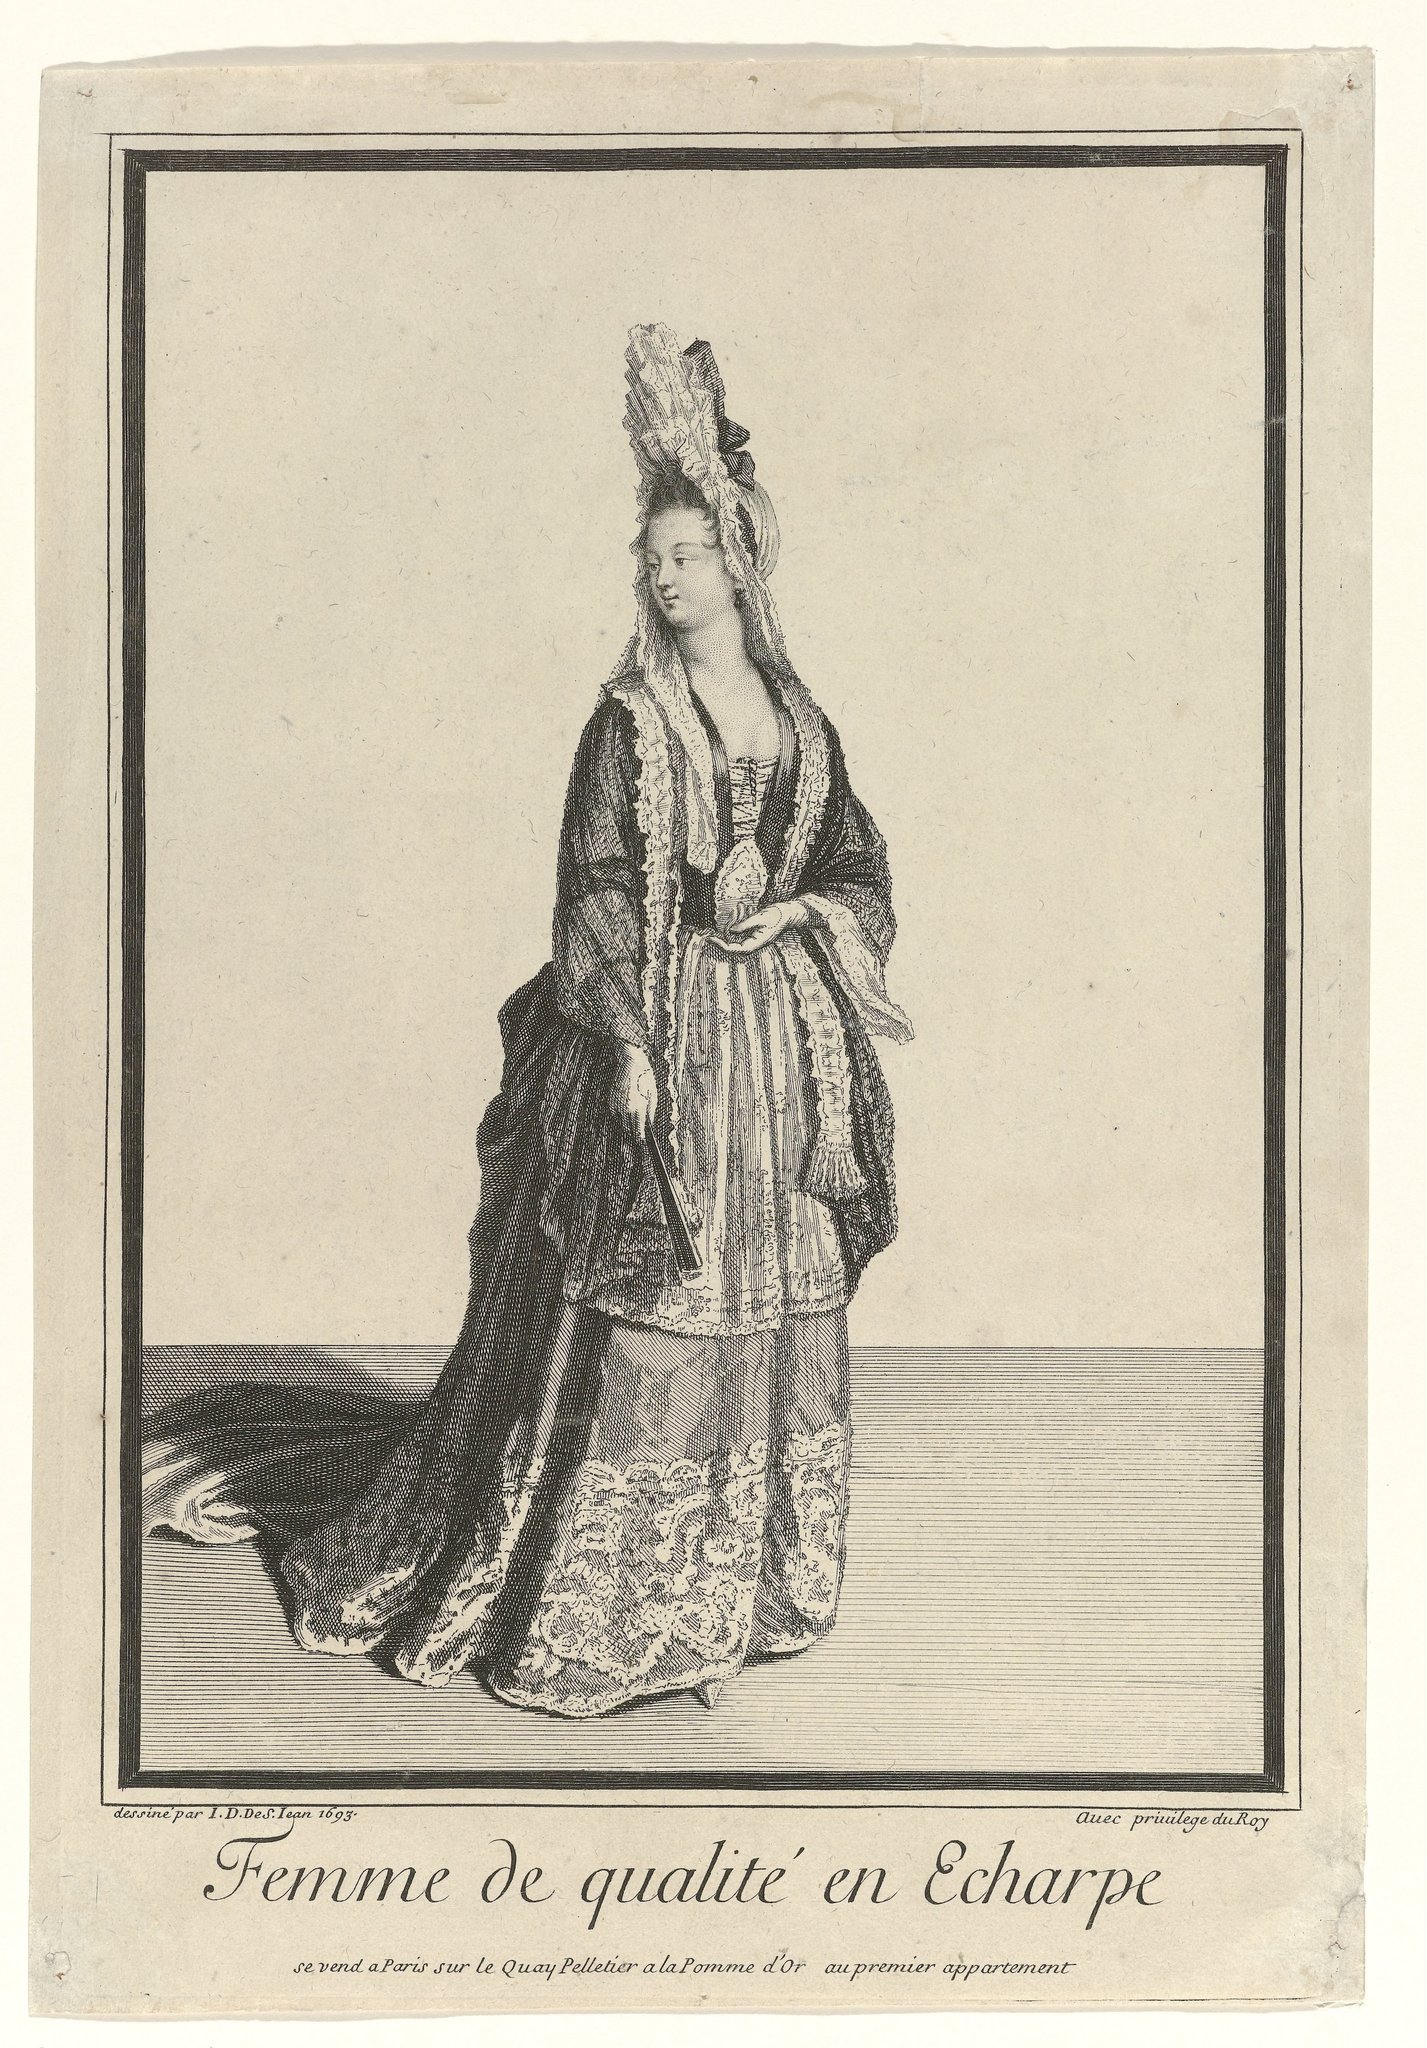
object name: costume print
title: Femme de qualité en Echarpe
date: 1693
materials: paper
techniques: etching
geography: paris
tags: piece of clothing covering the breast or décolleté (stomacher) (+ women's clothes), fashion plates, skirt (+ women's clothes), head-gear: fontange (+ women's clothes), fan (+ women's clothes), dress, gown: manteau (+ women's clothes), apron (+ women's clothes), neck-gear ~ clothing (+ women's clothes)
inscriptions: privilege: ‘avec privilege du Roy se vend a Paris sur le Quay Pelletier a la pomme d'or au premier appartement’, title: ‘Femme de qualité en Echarpe’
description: Vooraanstaande vrouw gekleed in een manteau met sleep en engageantes. Zij draagt een devant-de-gorge (borststuk), doorzichtige sjaal afgezet met een versierde rand en franjes, rok en sierschort. Op het hoge kapsel een fontangemuts met slippen. Accessoires: oorbellen, dunne sjaal afgezet met franjes, lange handschoenen en waaier. De prent maakt deel uit van een reeks van 73 kostuumprenten, getekend door J. D. de Saint-Jean, Parijs, 1683-1694.